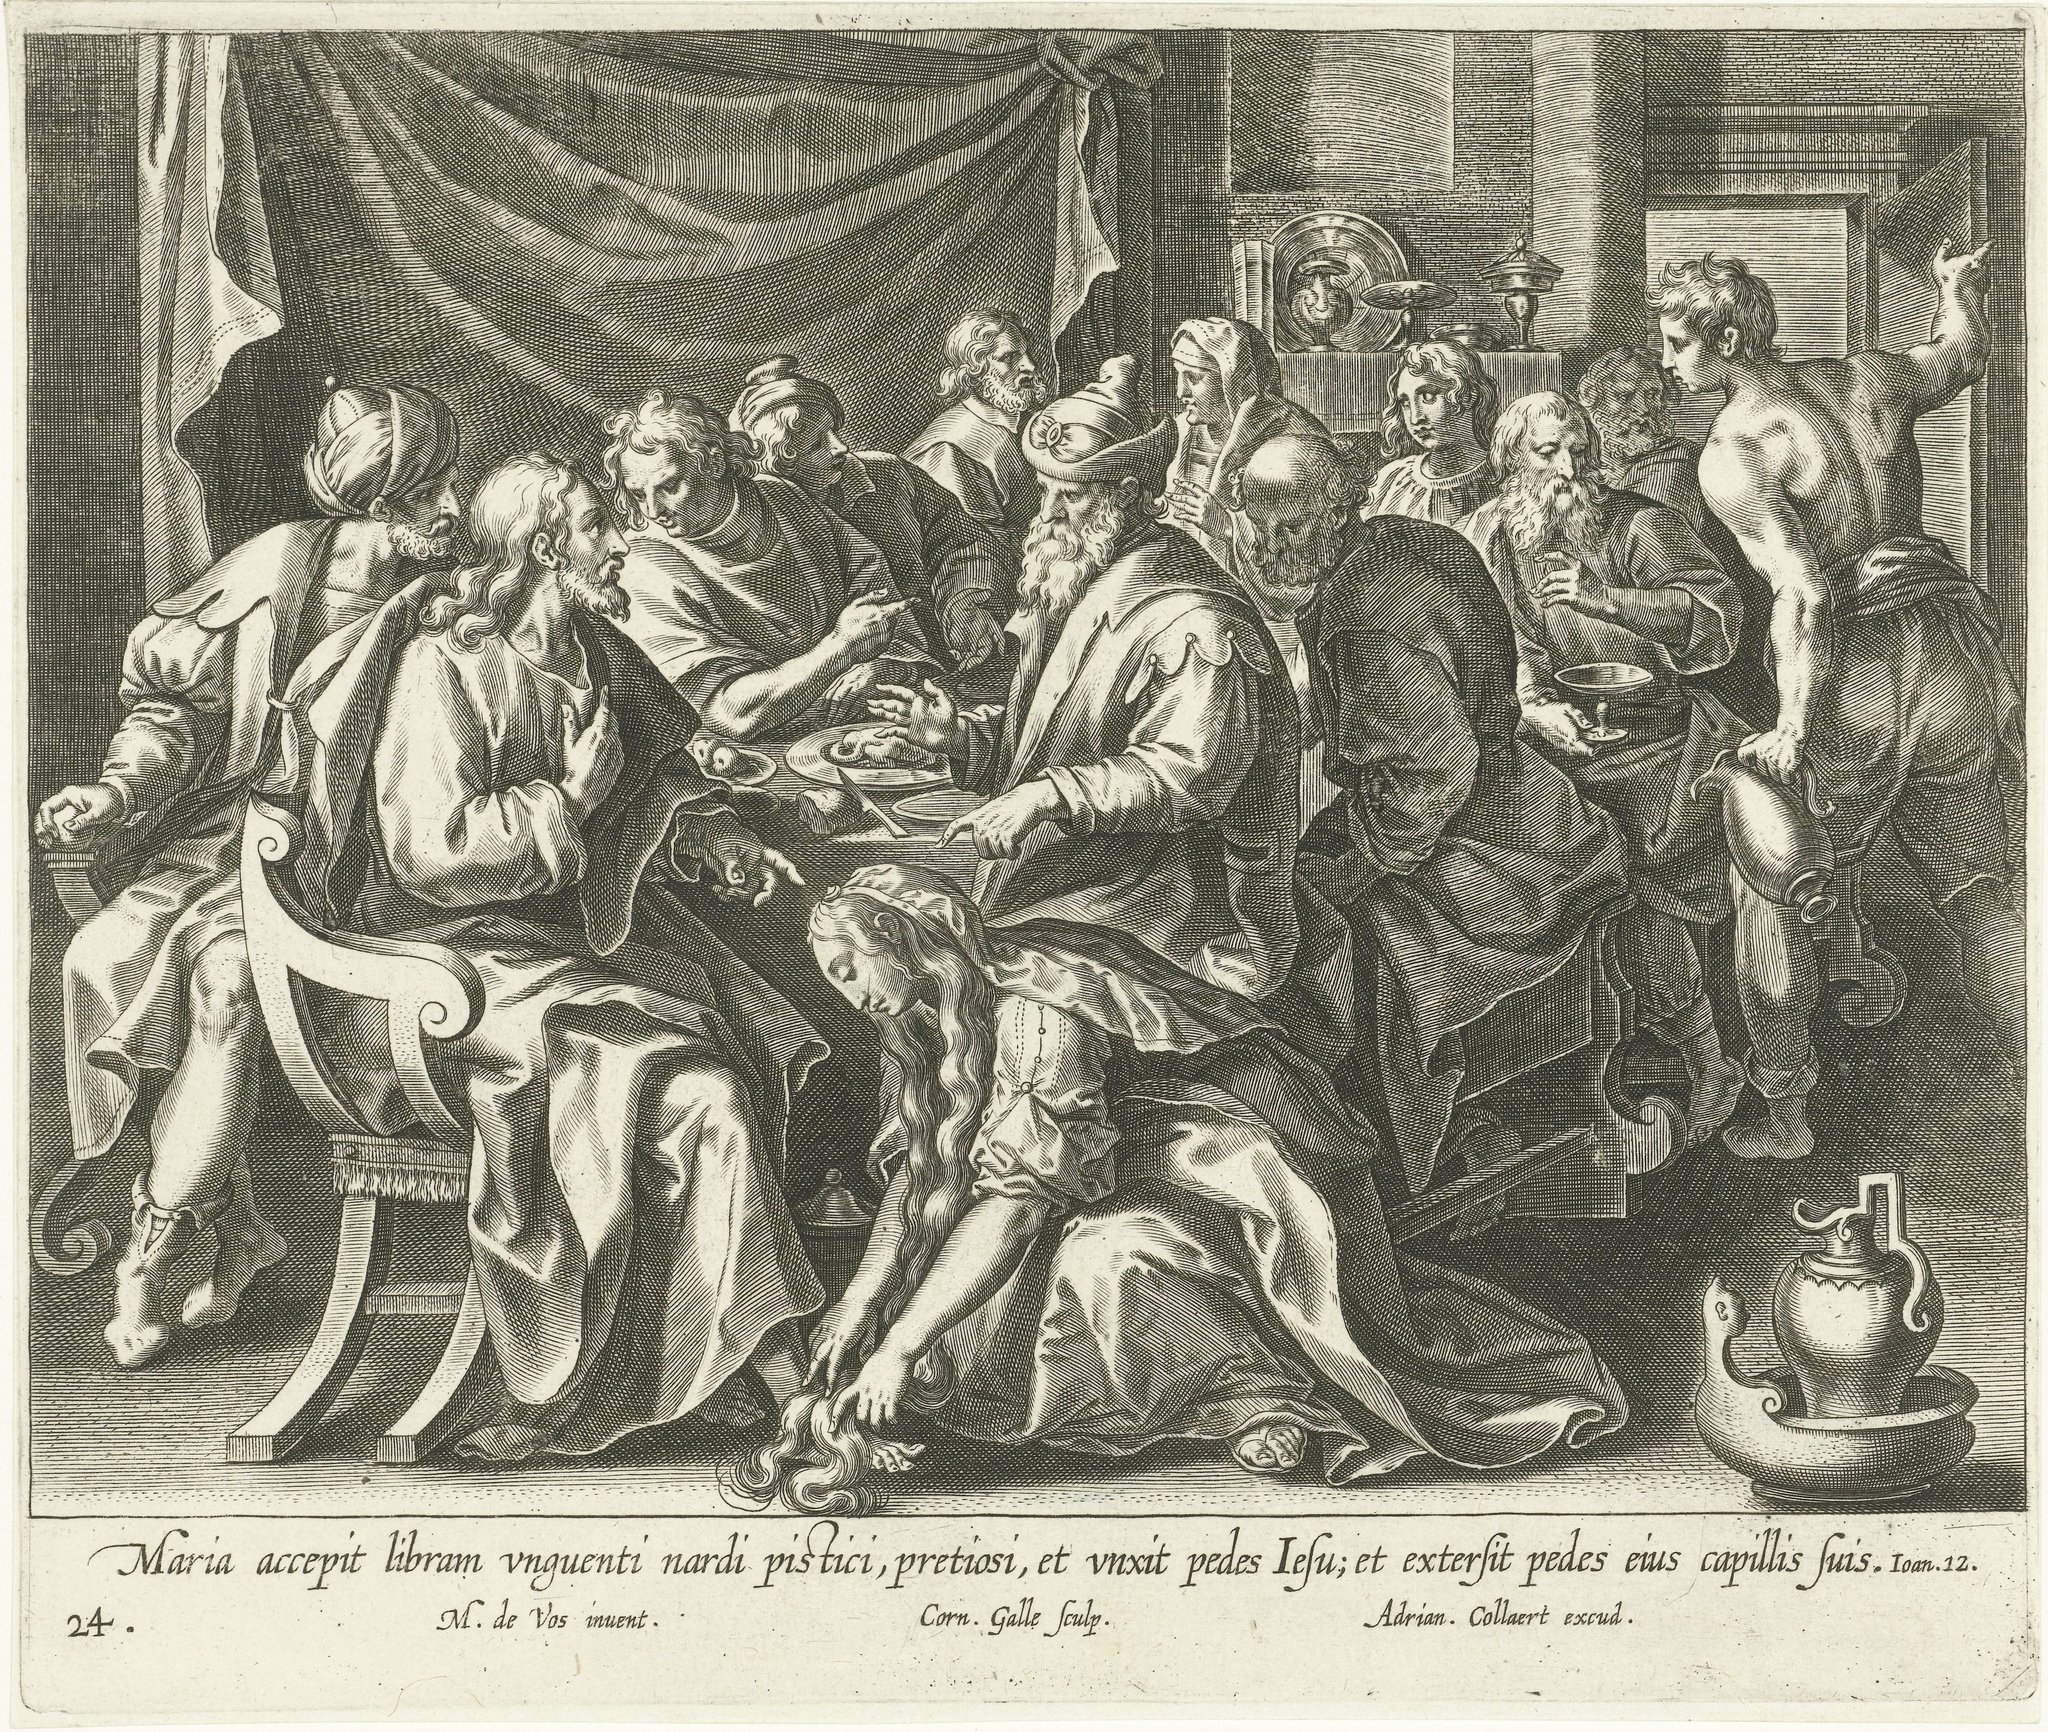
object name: print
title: Leven, passie en wederopstanding van Christus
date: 1598-1618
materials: paper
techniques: engraving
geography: antwerp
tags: a woman washes christ's feet with her tears, and wipes them with her hair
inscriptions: collector's mark: Lugt 2228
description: Maria Magdalena, een lichtekooi, droogt de voeten van Christus met haar haren. Ze gaat vervolgens de voeten zalven. Judas Iskariot protesteert maar Christus legt uit dat men haar moet vergeven (Lucas 7:36-50). De prent heeft een Latijns onderschrift. De prent maakt deel uit van een serie over het leven van Christus.